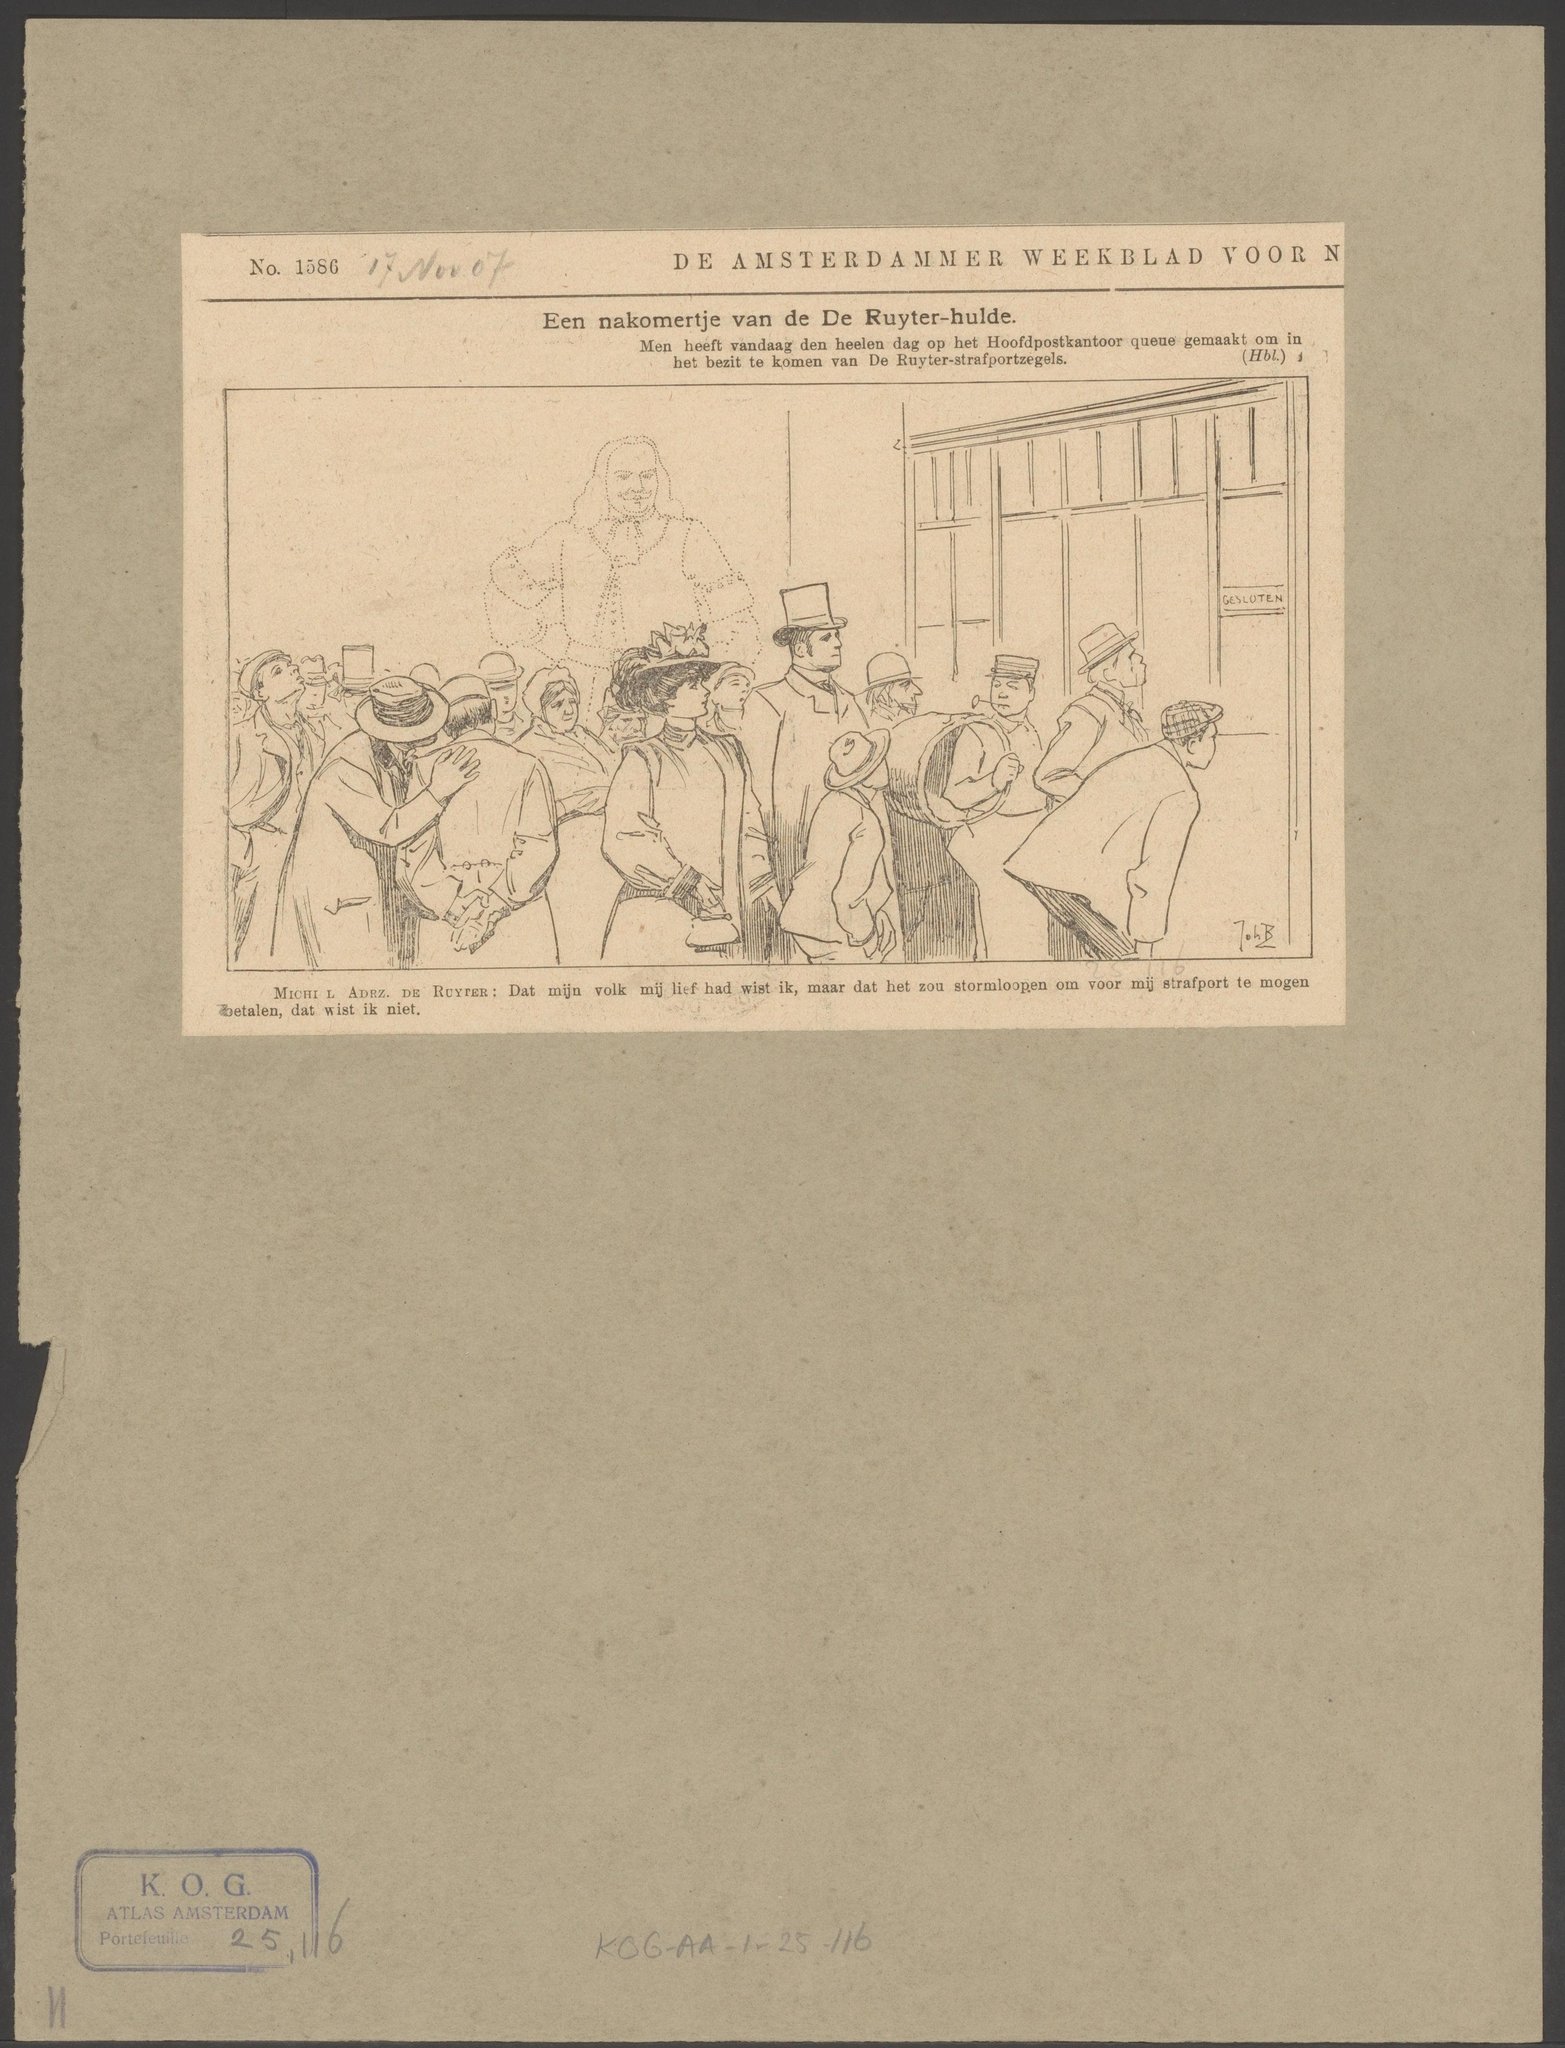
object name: photomechanical print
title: Menigte in de rij voor strafportzegels van Michiel Adriaenszoon de Ruyter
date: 1907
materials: paper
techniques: letterpress printing, line block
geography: amsterdam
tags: michiel adriaenszoon de ruyter, counter ~ shop, commander-in-chief, admiral, historical persons (portraits and scenes from the life)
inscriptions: collector's mark: ‘25.116’ Lugt 1641b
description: Onderwerpsrubriek binnen de Atlas Amsterdam: Krijgswezen I: De Admiraliteit van Amsterdam, C. Michiel Adriaensz. de Ruyter.